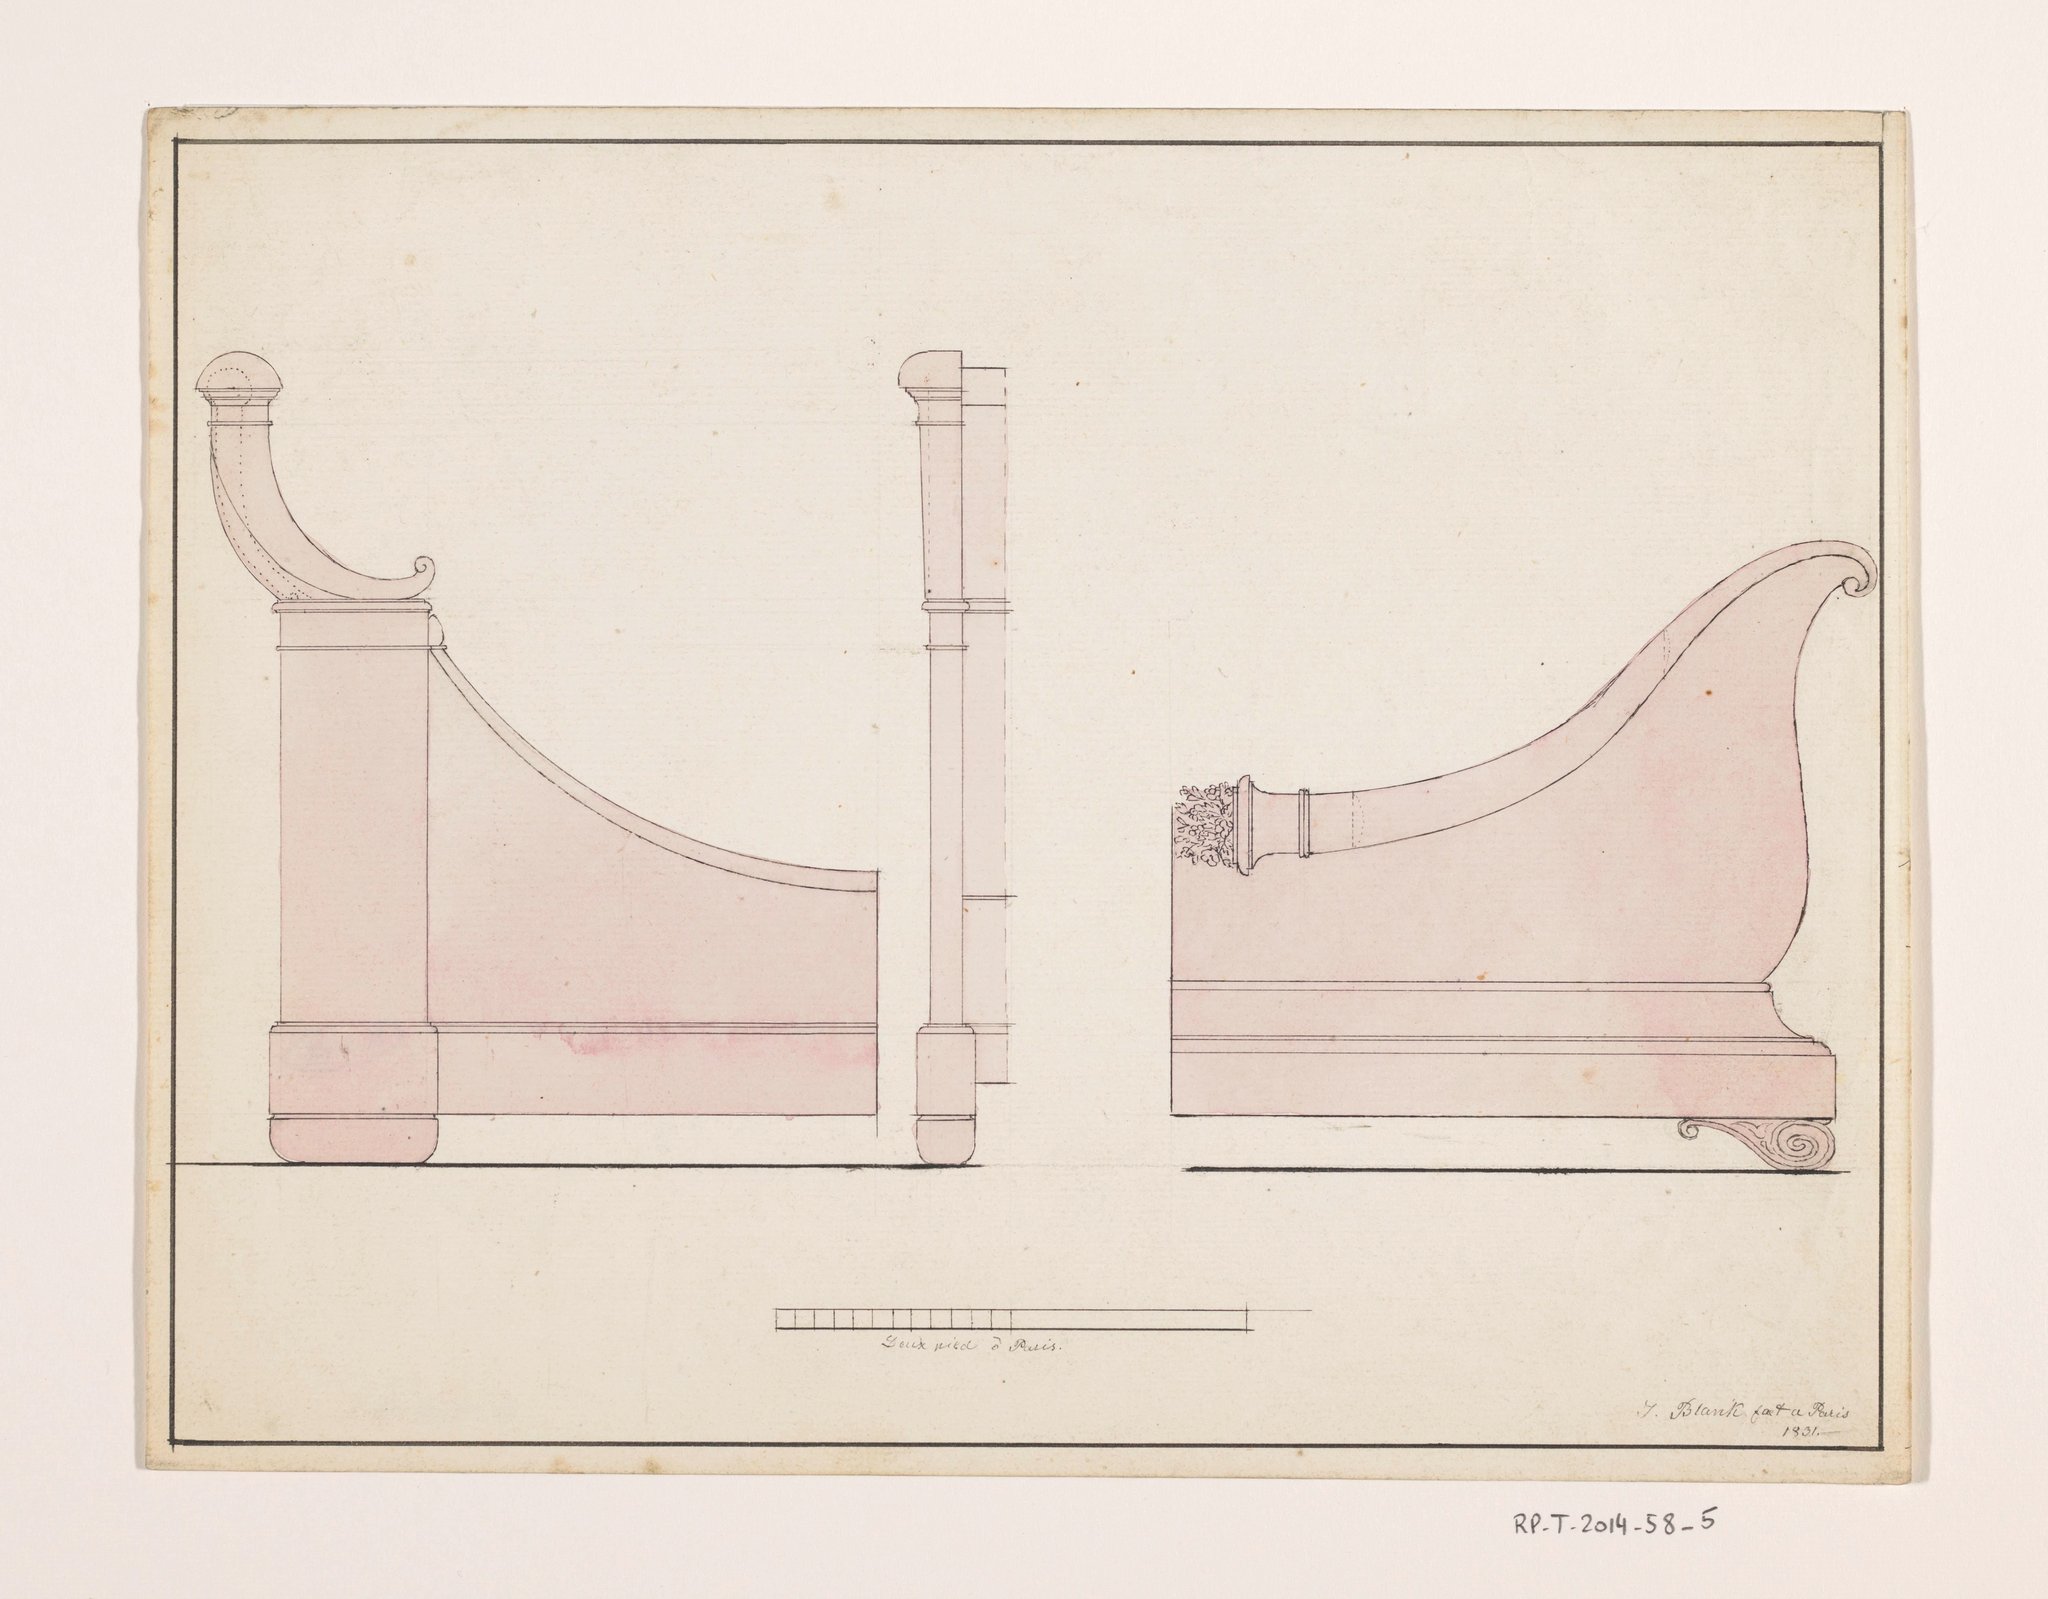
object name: design drawing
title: Ontwerpen voor bedden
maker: joachim-pierre blank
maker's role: draughtsman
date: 1831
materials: ink, paper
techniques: brush, pen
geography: paris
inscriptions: signature and date: ‘I. Blank faet a Paris / 1831.’, inscription: ‘Deux pied d Paris.’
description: Ontwerp voor de (halve) voorzijde en de zijkant van een bed en voor de (halve) voorzijde van een tweede bed.